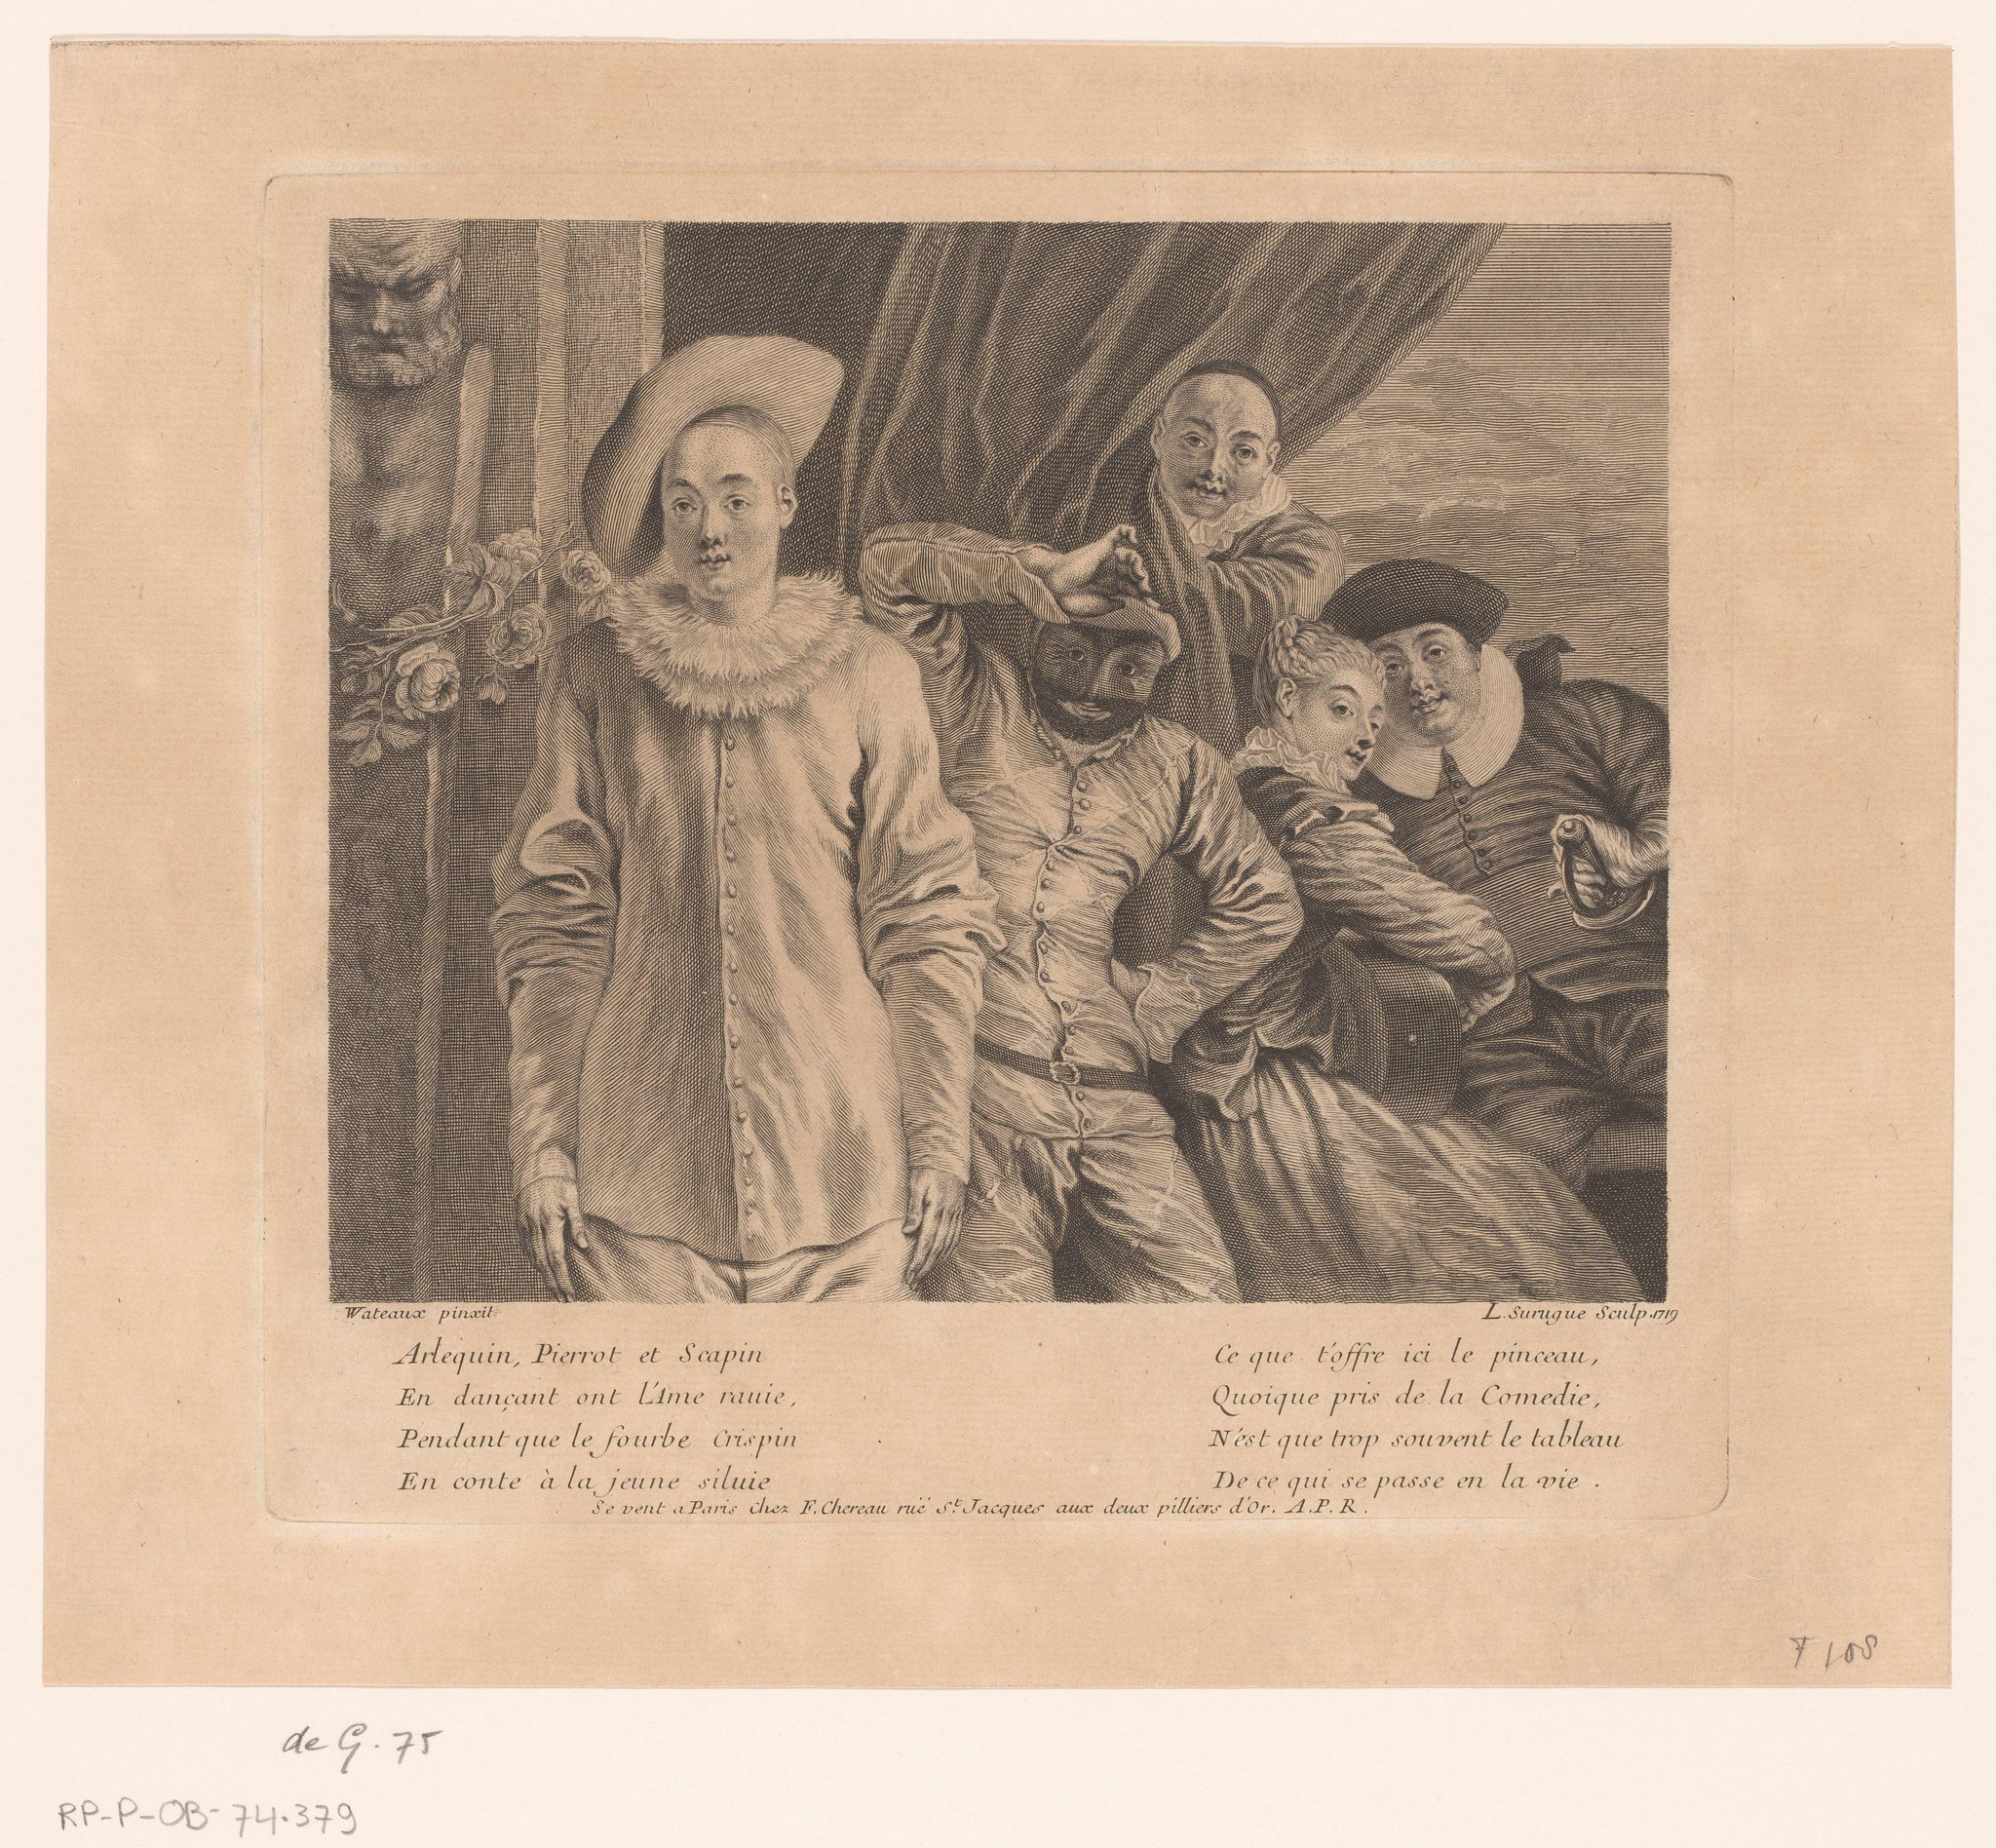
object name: print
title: L'Oeuvre d'Antoine Watteau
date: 1719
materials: paper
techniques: engraving, etching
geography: paris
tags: types in 'commedia dell'arte': pierrot, group of actors, troupe; actors on the stage, types in 'commedia dell'arte': harlequin, 'commedia dell'arte'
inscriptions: collector's mark: Lugt 2228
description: Gezelschap van acteurs waaronder Harlequin, Pierrot en Scapino.